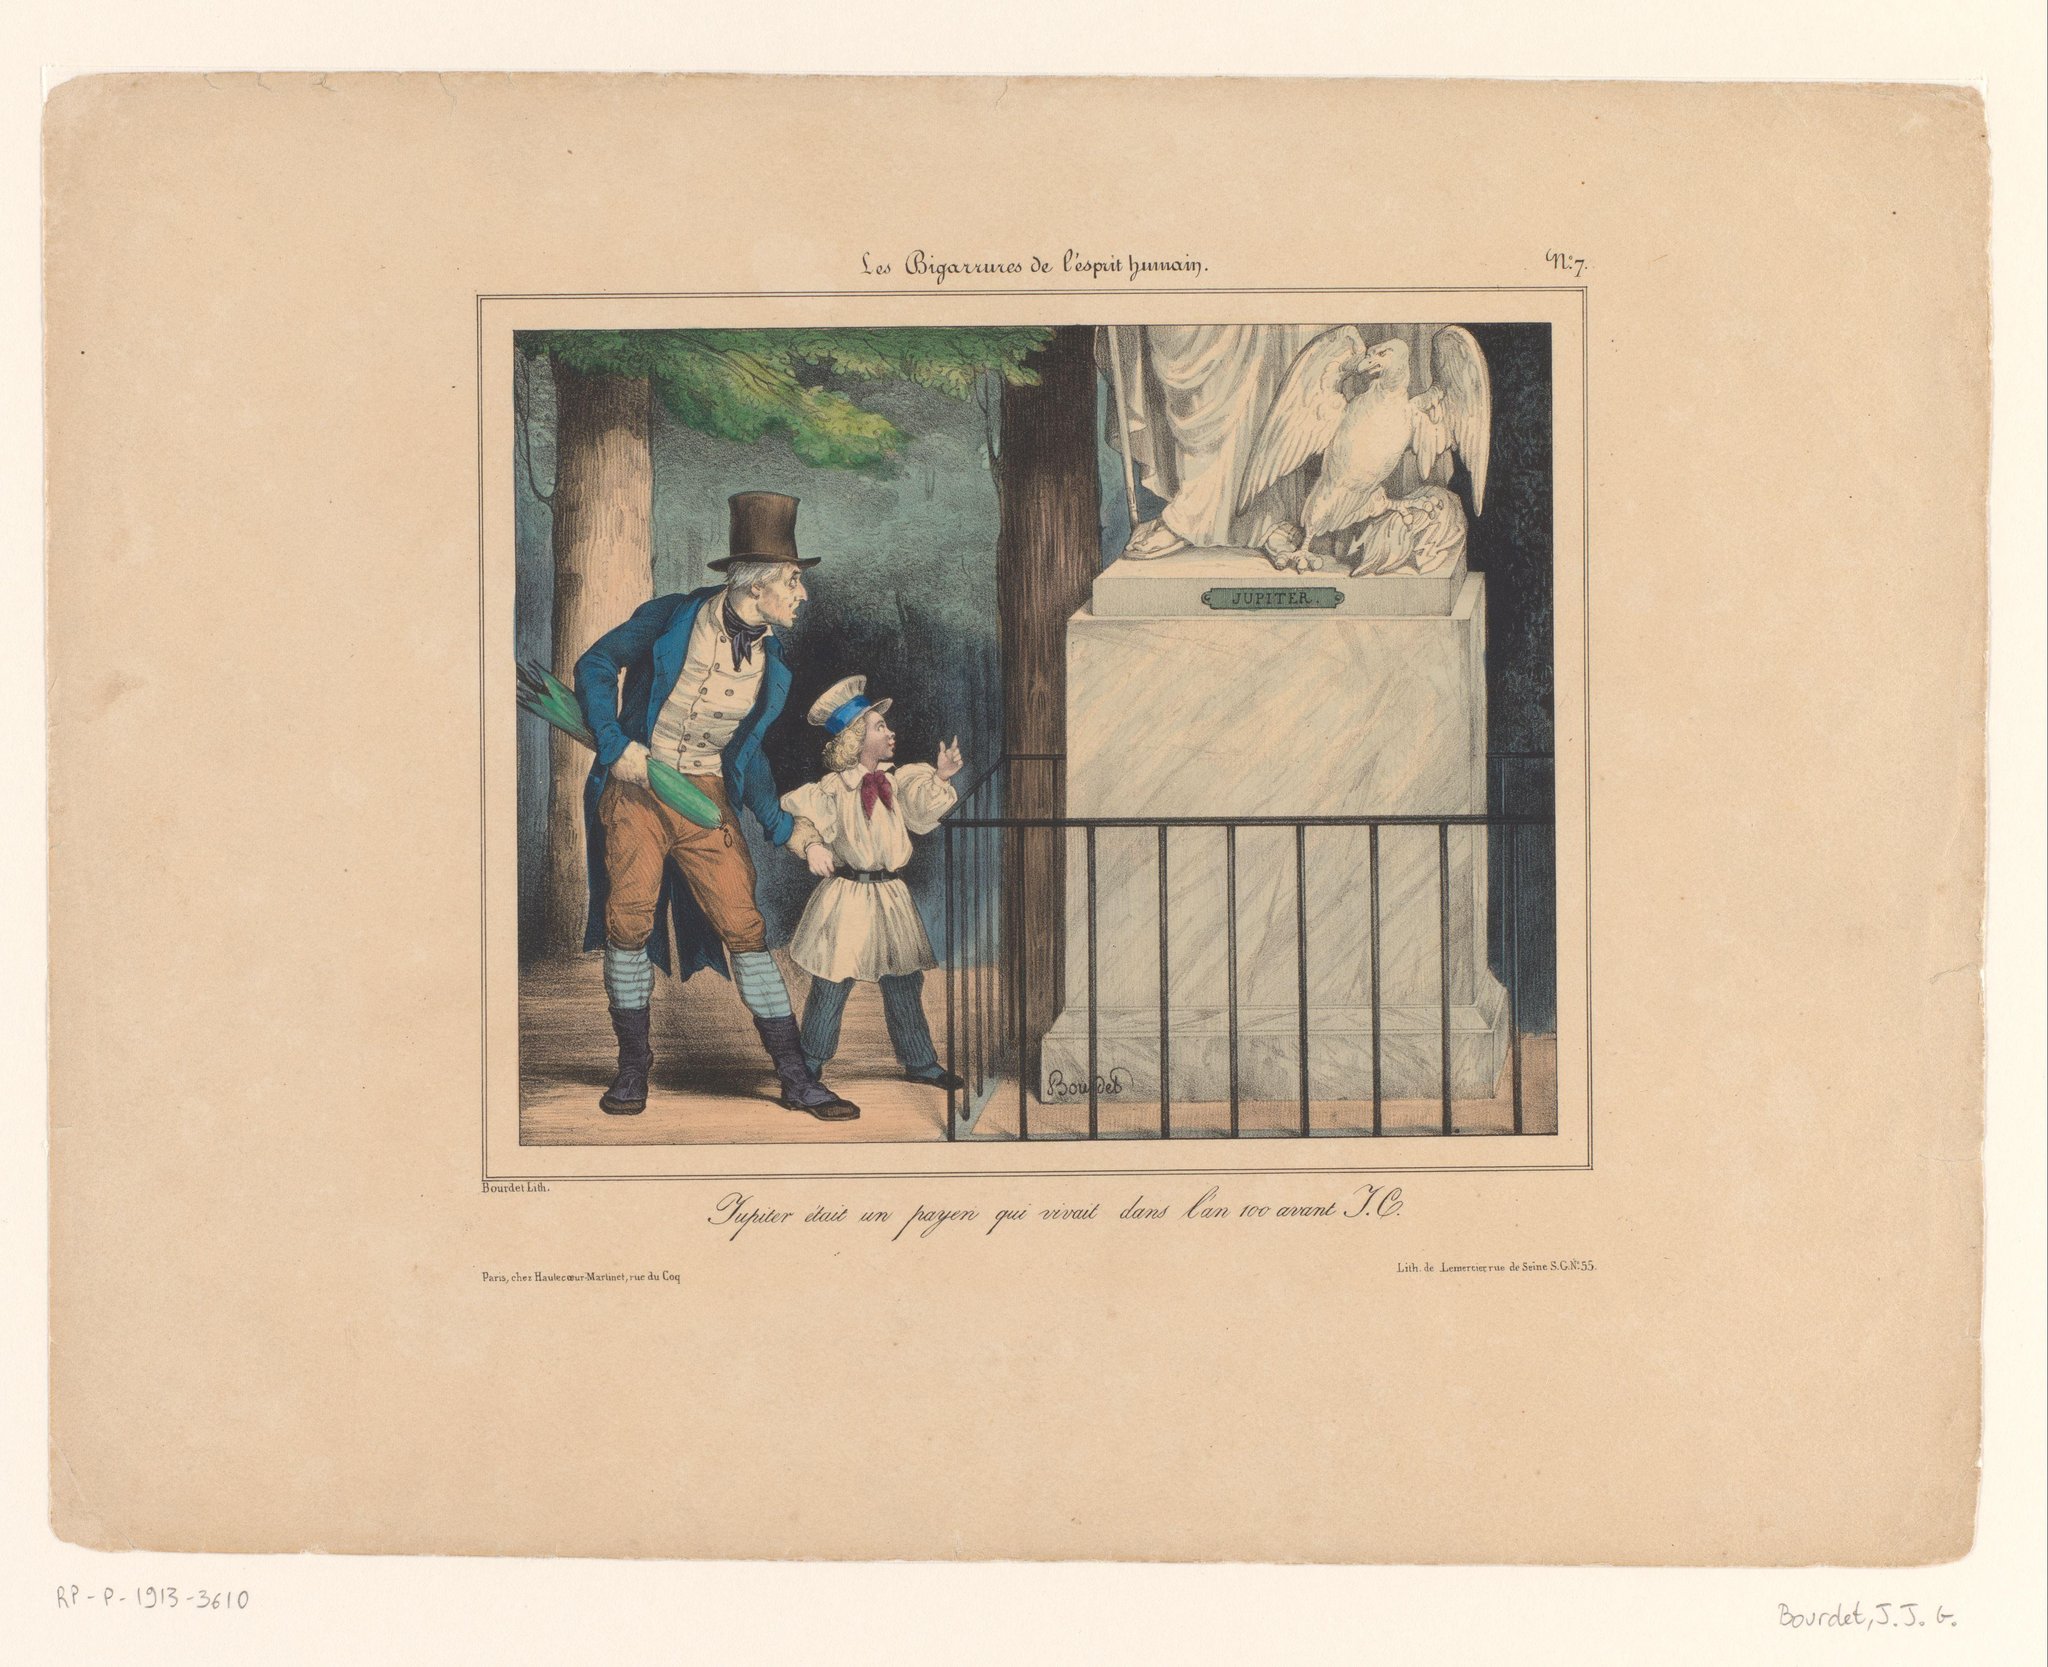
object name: cartoon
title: Veelkleurigheid van de menselijke geest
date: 1835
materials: paper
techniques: hand coloring, lithograph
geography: paris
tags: (story of) jupiter (zeus), sculpture, father and son(s) (family group), attributes of jupiter: eagle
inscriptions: collector's mark: Lugt 2233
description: Een vader wandelt met zijn jonge zoon langs een standbeeld van Jupiter. De jongen wijst omhoog naar het beeld, maar de vader pakt hem bij de arm om door te lopen. Hij zegt dat Jupiter een heiden was die in het jaar honderd voor Christus leefde.